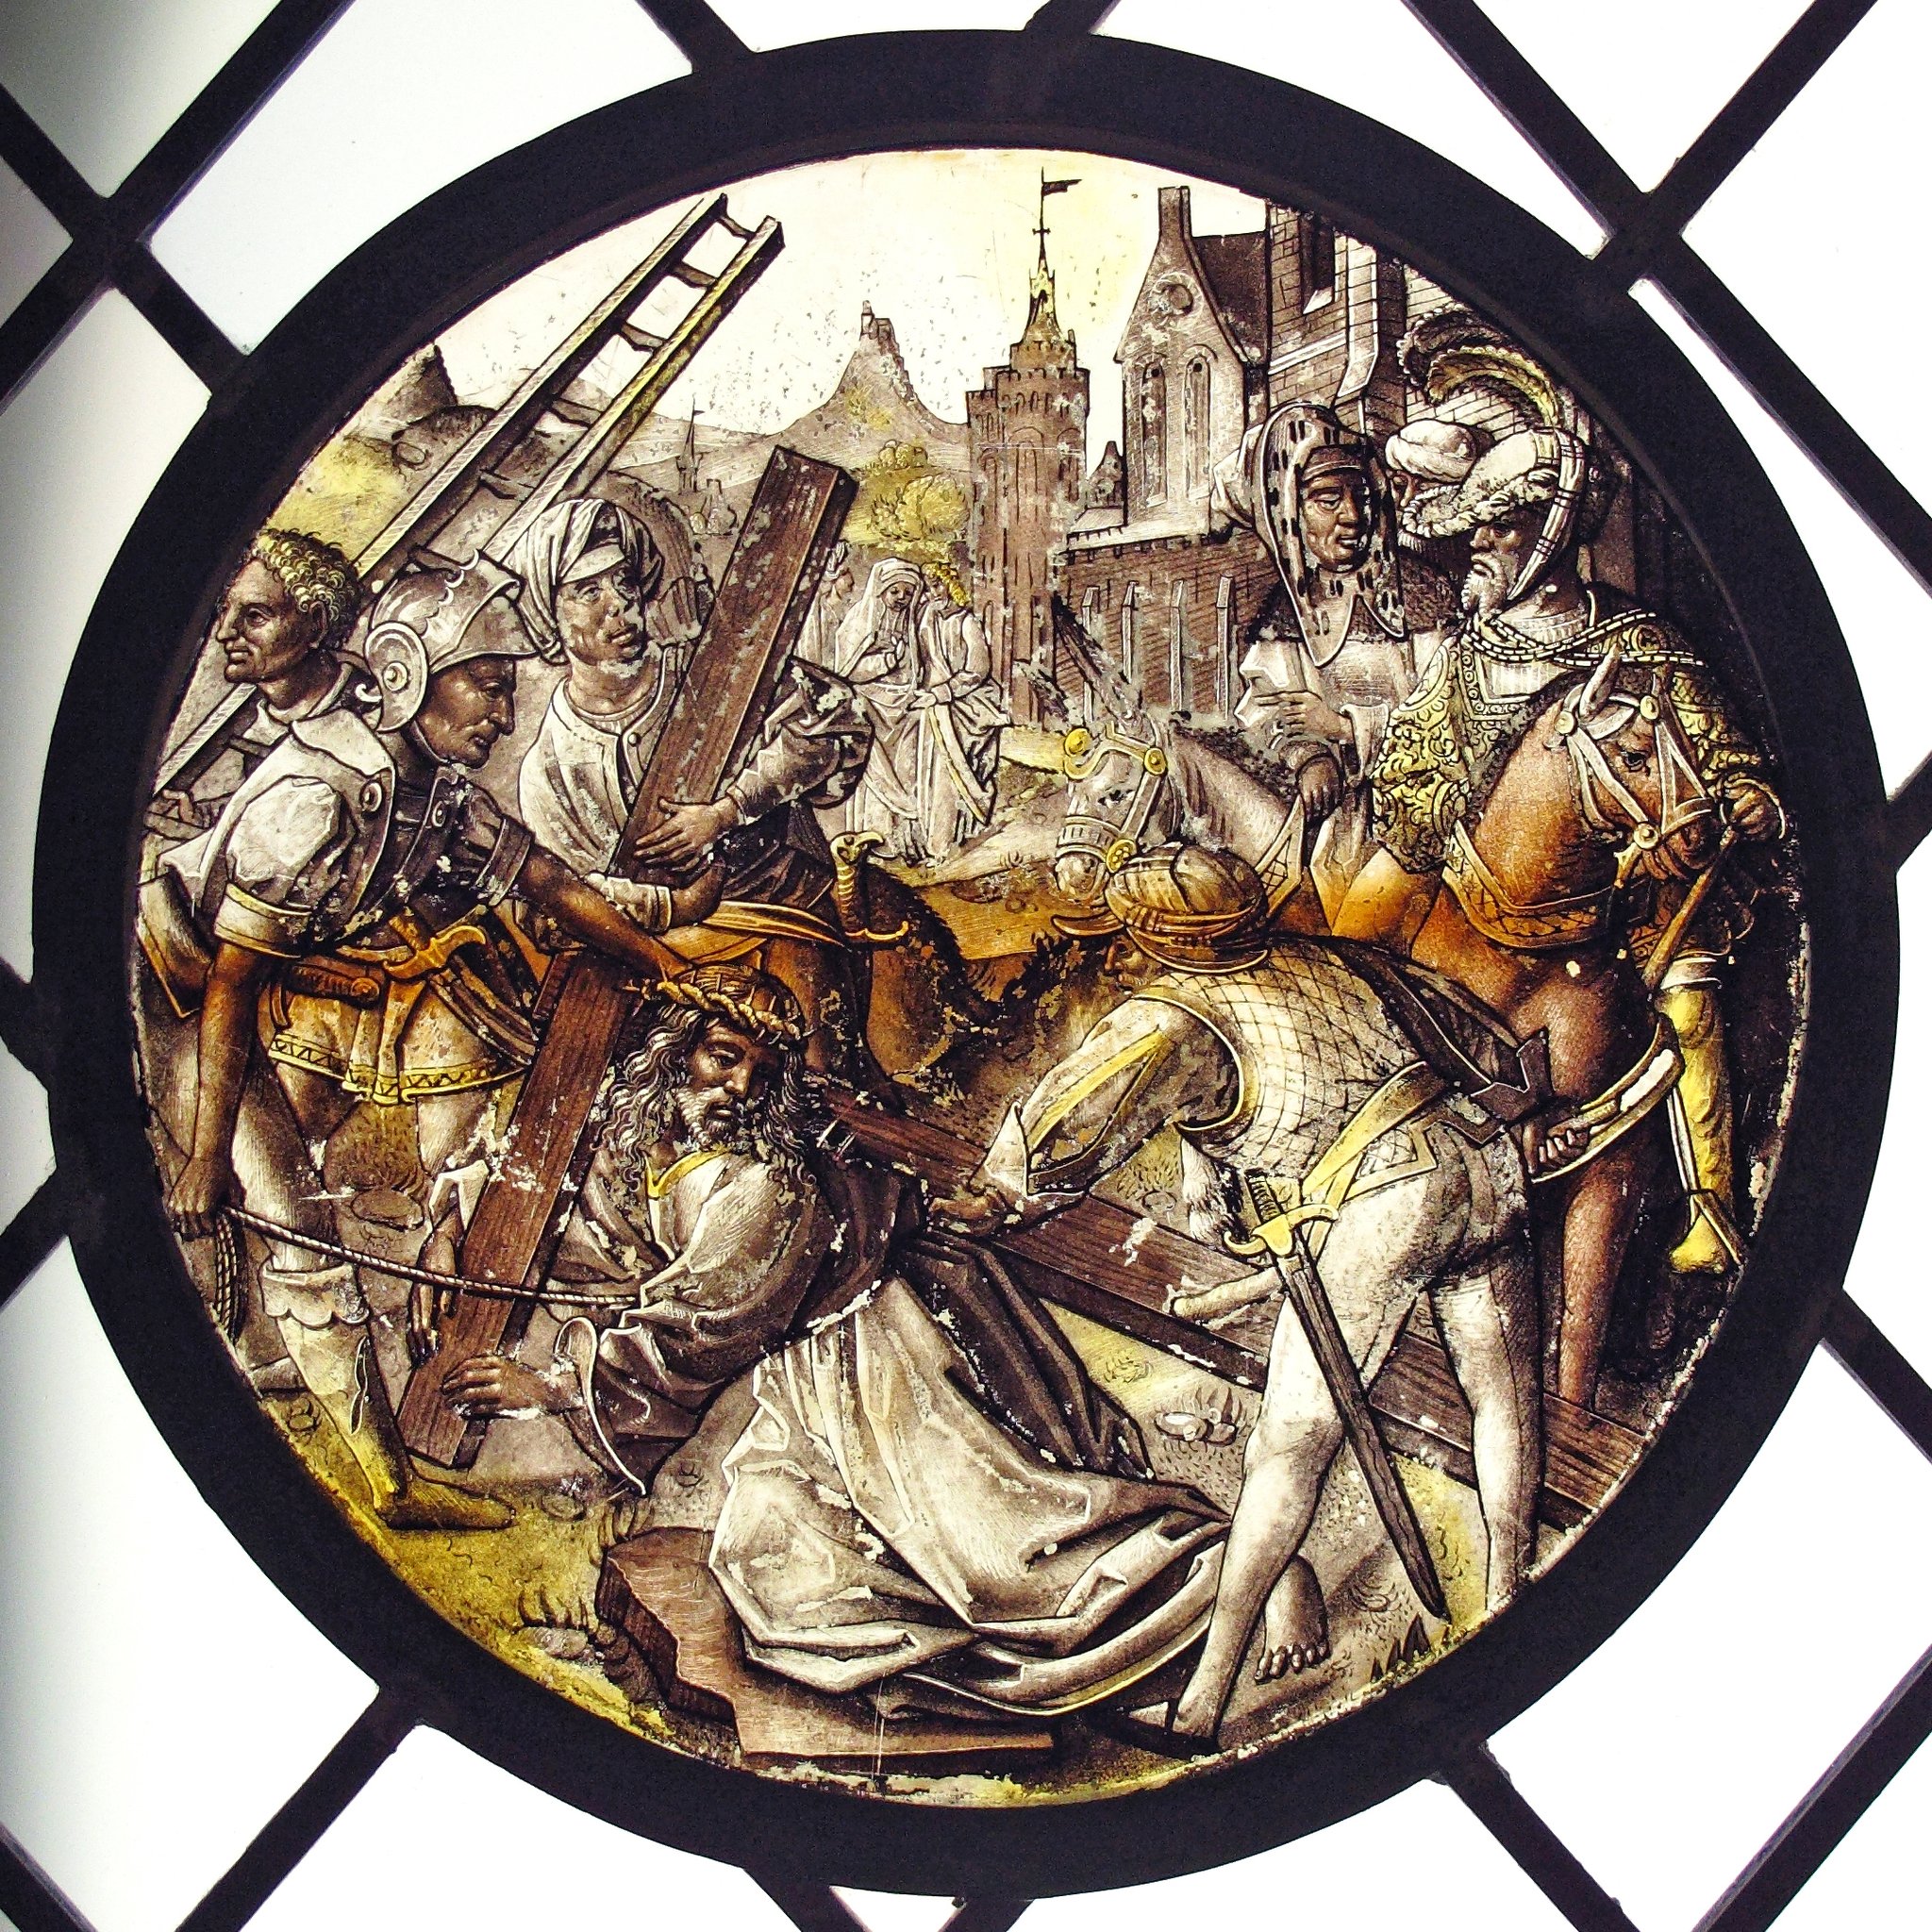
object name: roundel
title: Roundel with Christ Bearing the Cross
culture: dutch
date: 1520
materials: glass, paint, pigment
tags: soldiers,men,horses,christ,bearing the cross